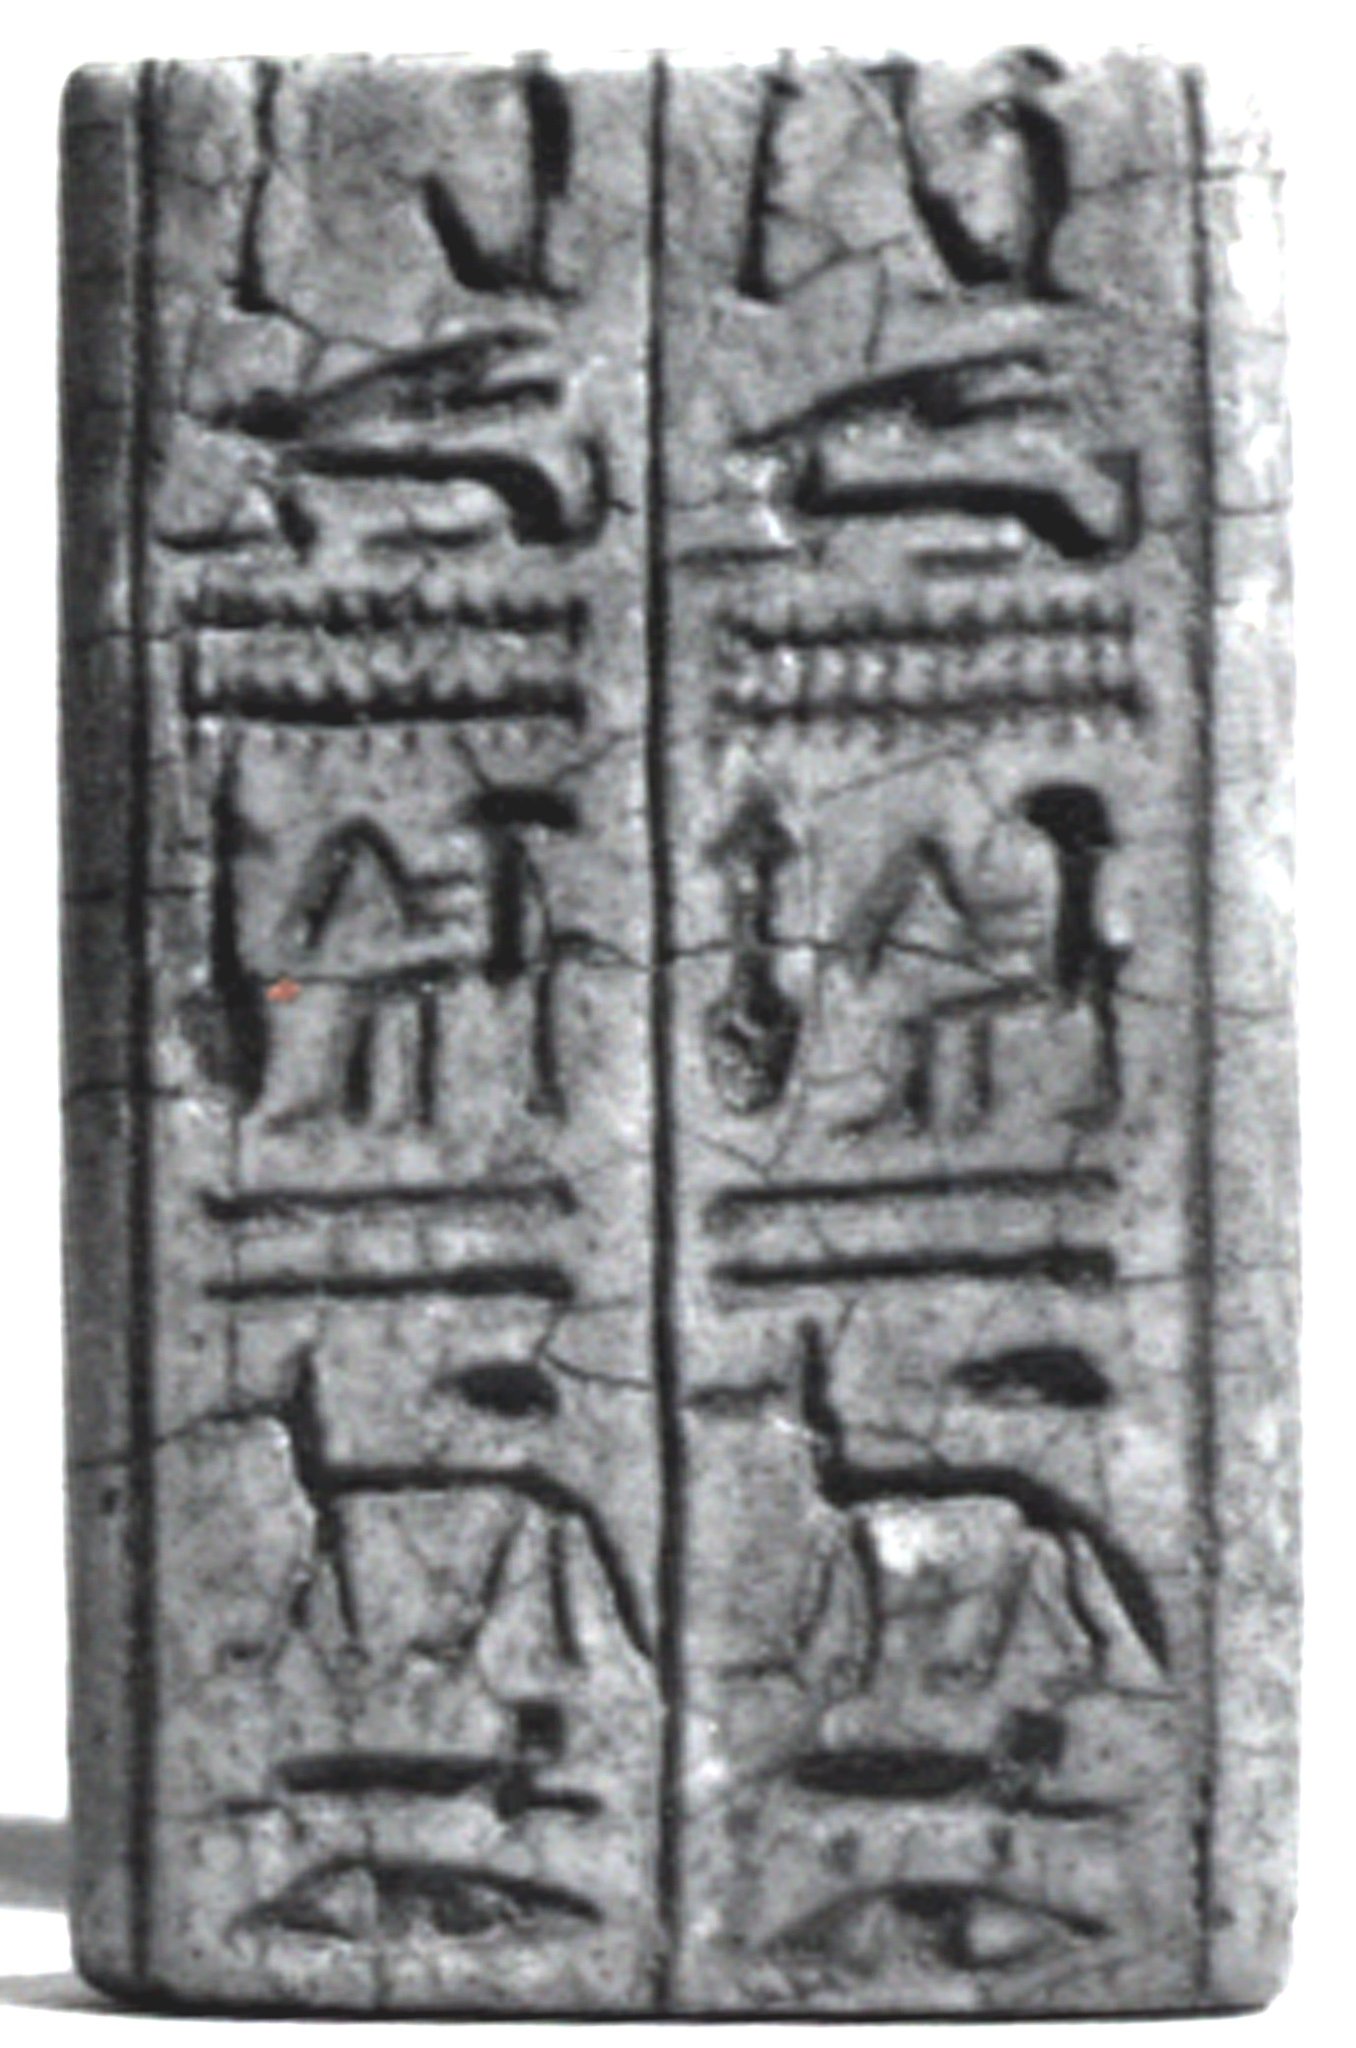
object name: plaque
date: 712-343 BCE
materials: stone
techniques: glazing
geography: egypt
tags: hieroglyphs